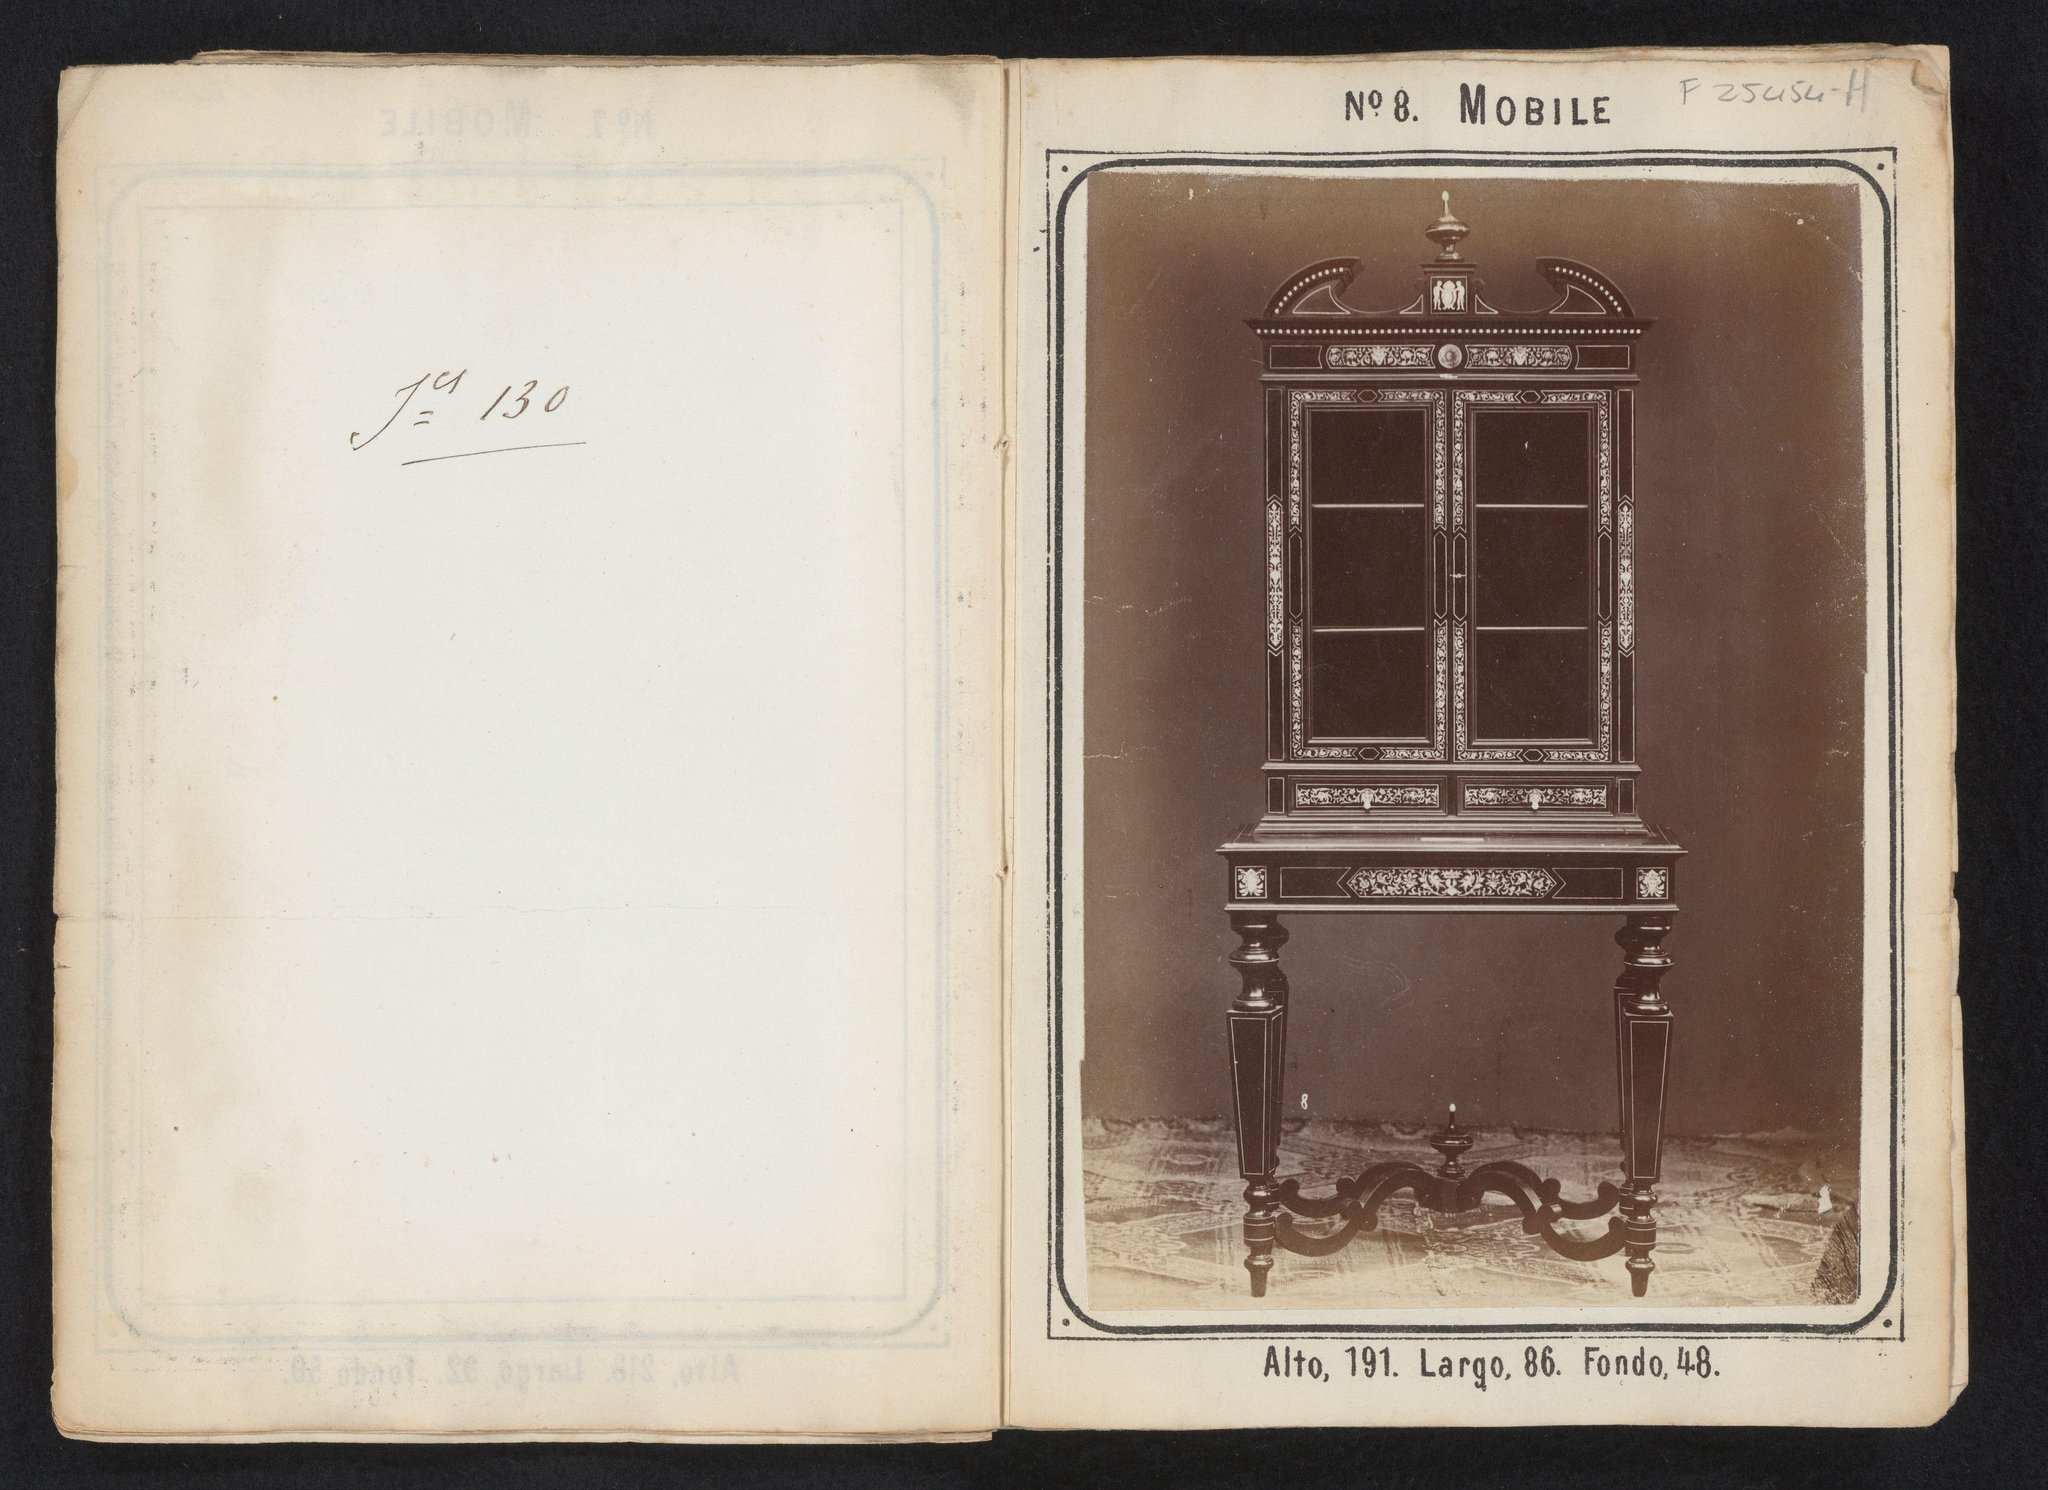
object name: photograph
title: No 8 Mobile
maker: Anonymous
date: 1878-1885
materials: paper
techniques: albumen print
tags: writing-table, writing-desk, cupboard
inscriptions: inscription: ‘Alto, 191. Largo, 86. Fondo, 48.’, inscription: ‘Ies. 280’